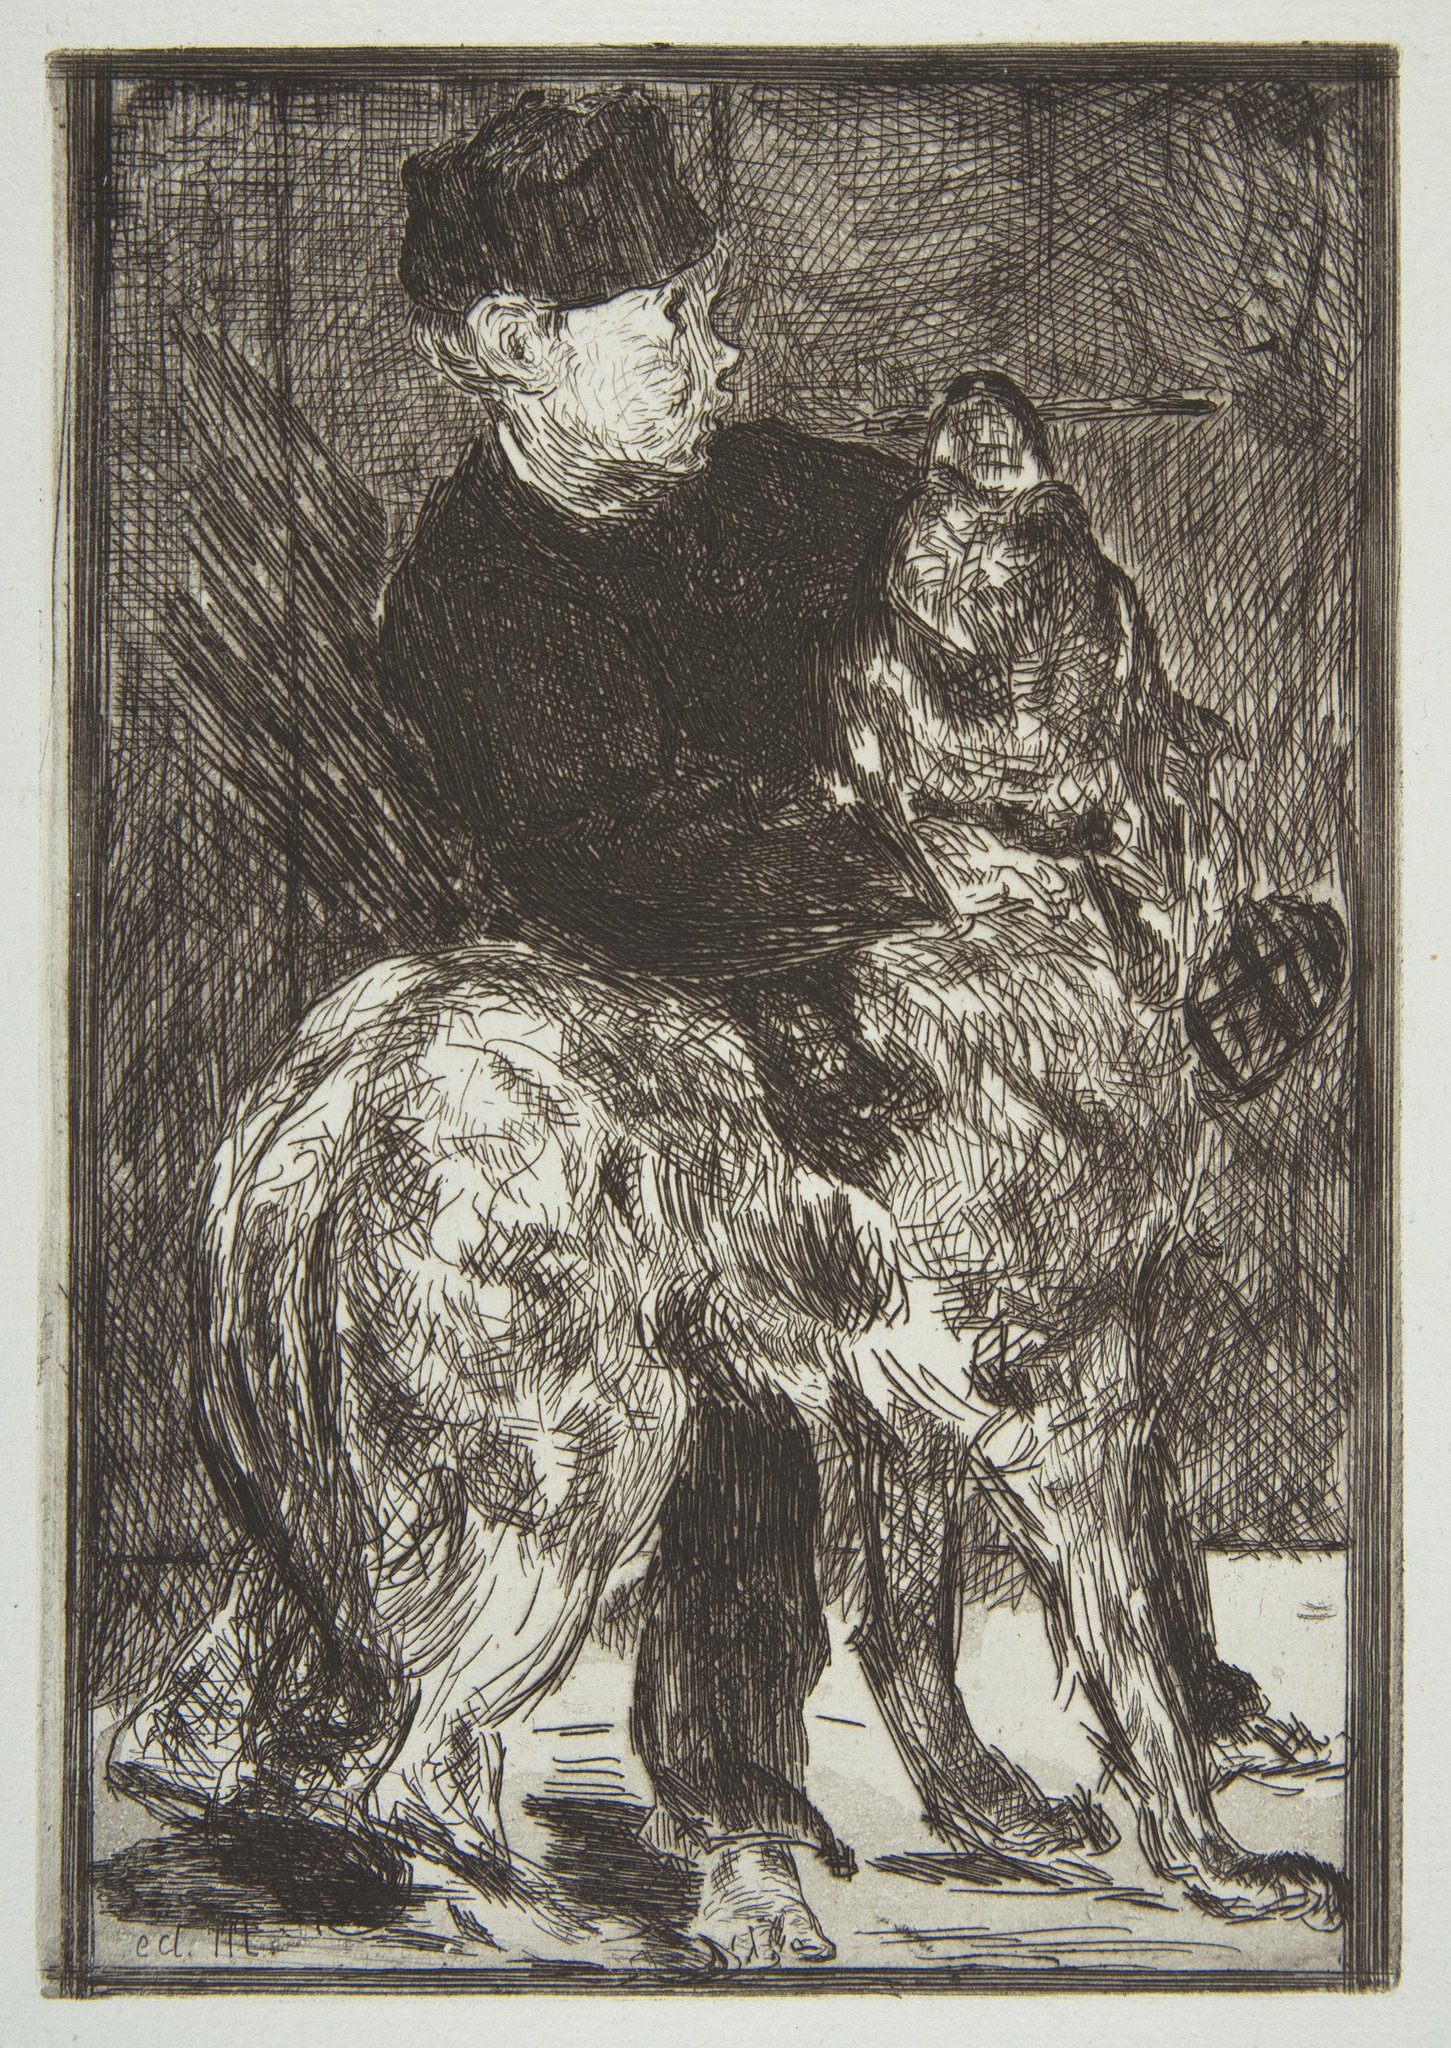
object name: print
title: Boy and Dog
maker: édouard manet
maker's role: artist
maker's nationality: french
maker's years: 1832-1883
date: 1862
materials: paper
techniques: aquatint, etching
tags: boys,dogs